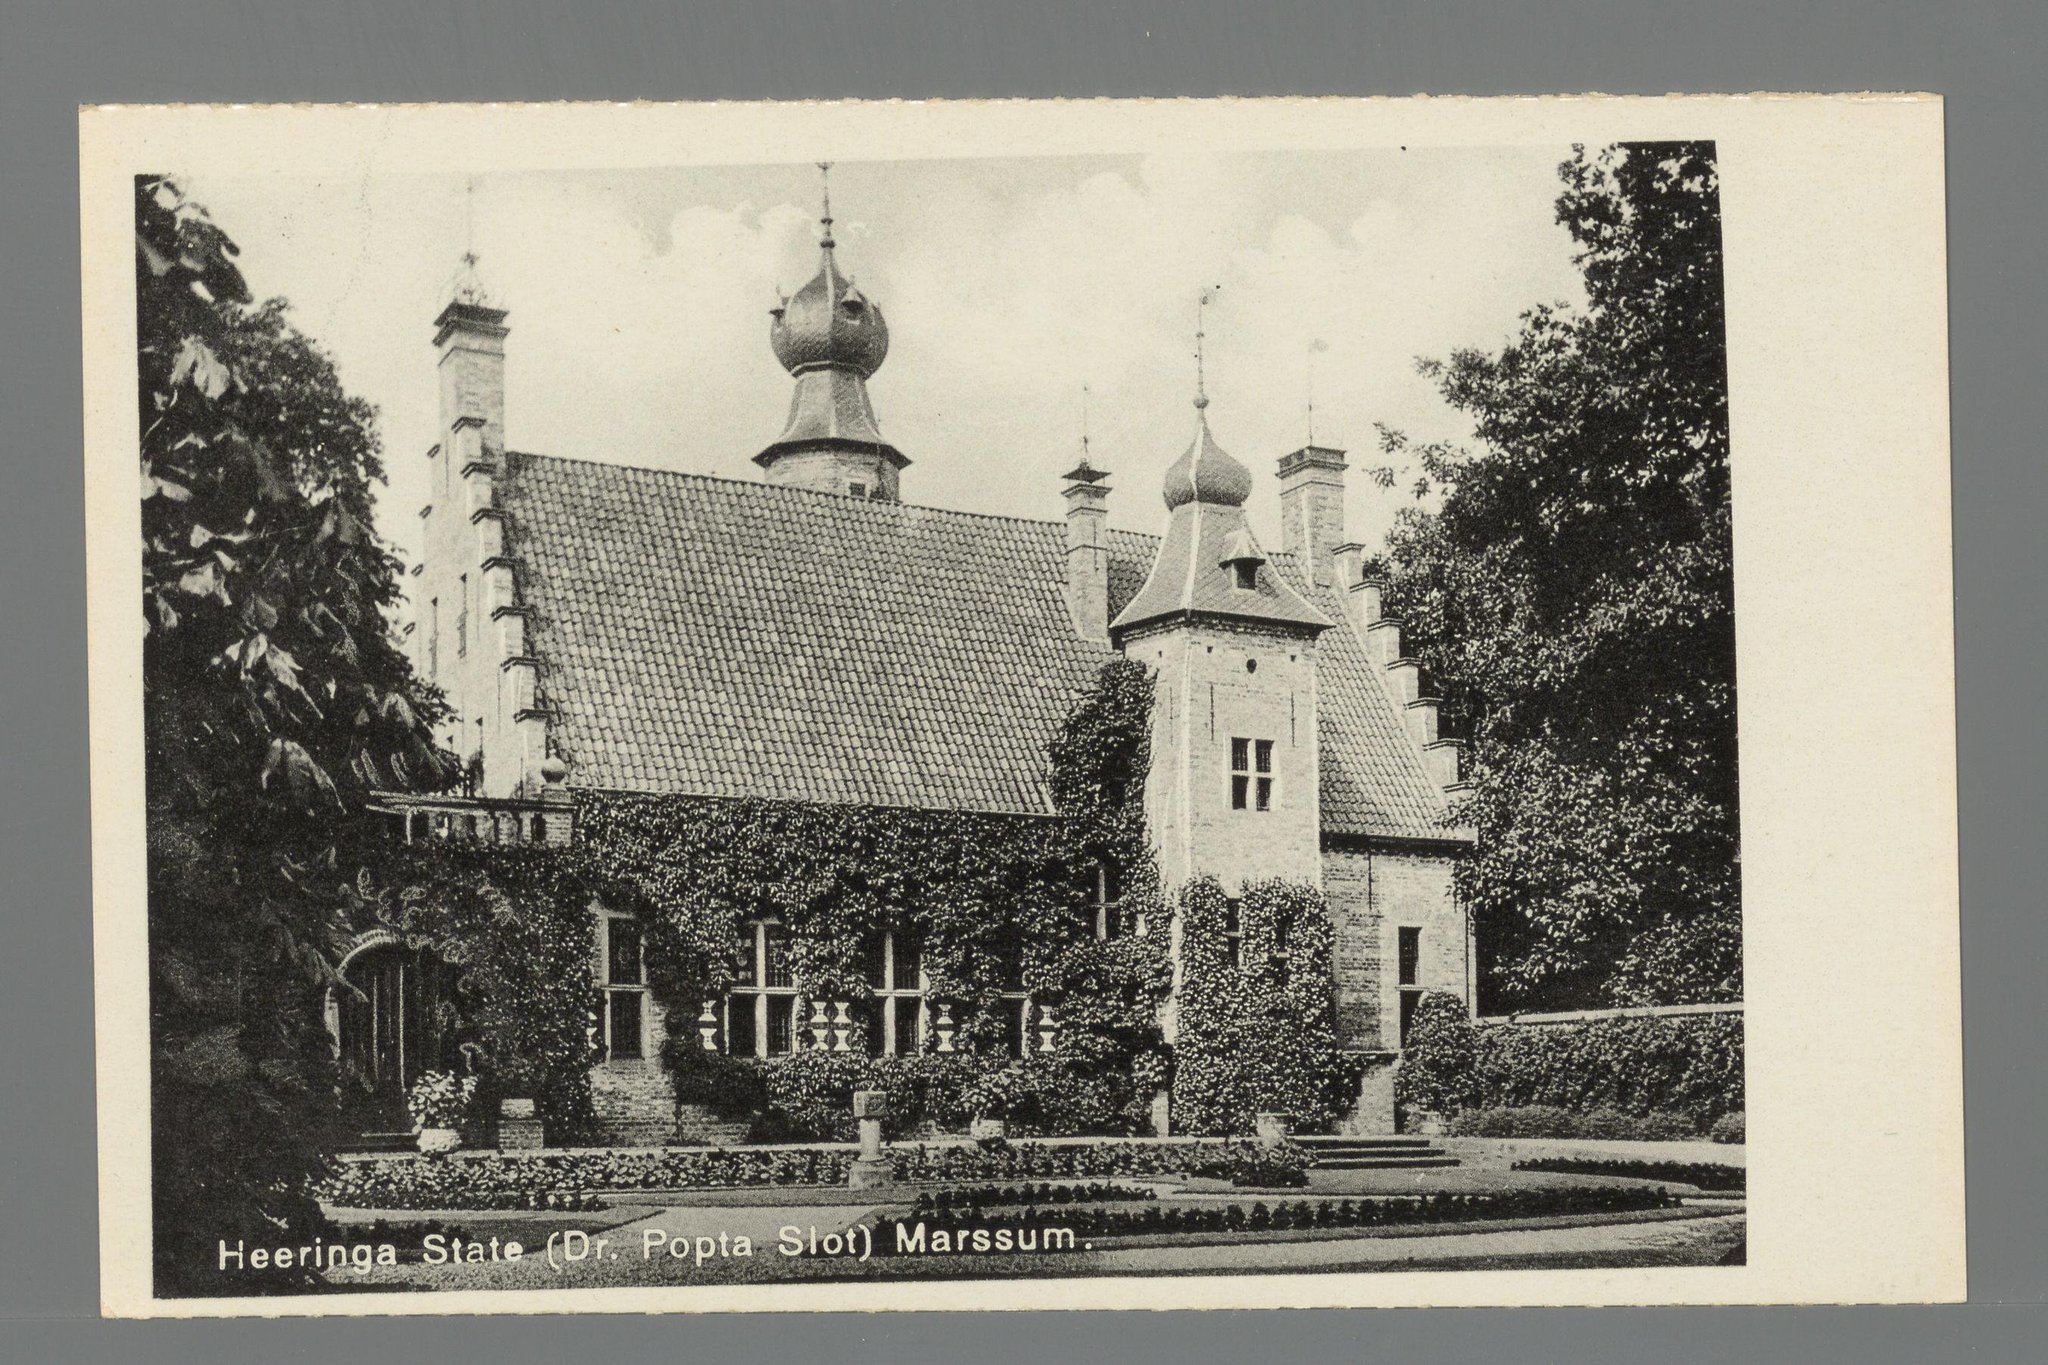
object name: ansichtkaart, prentbriefkaart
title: Heeringa State (Dr. Popta Slot) Marssum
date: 1913-1950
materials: cardboard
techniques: photograph, writing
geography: marssum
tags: castle, permanent exhibition, museum